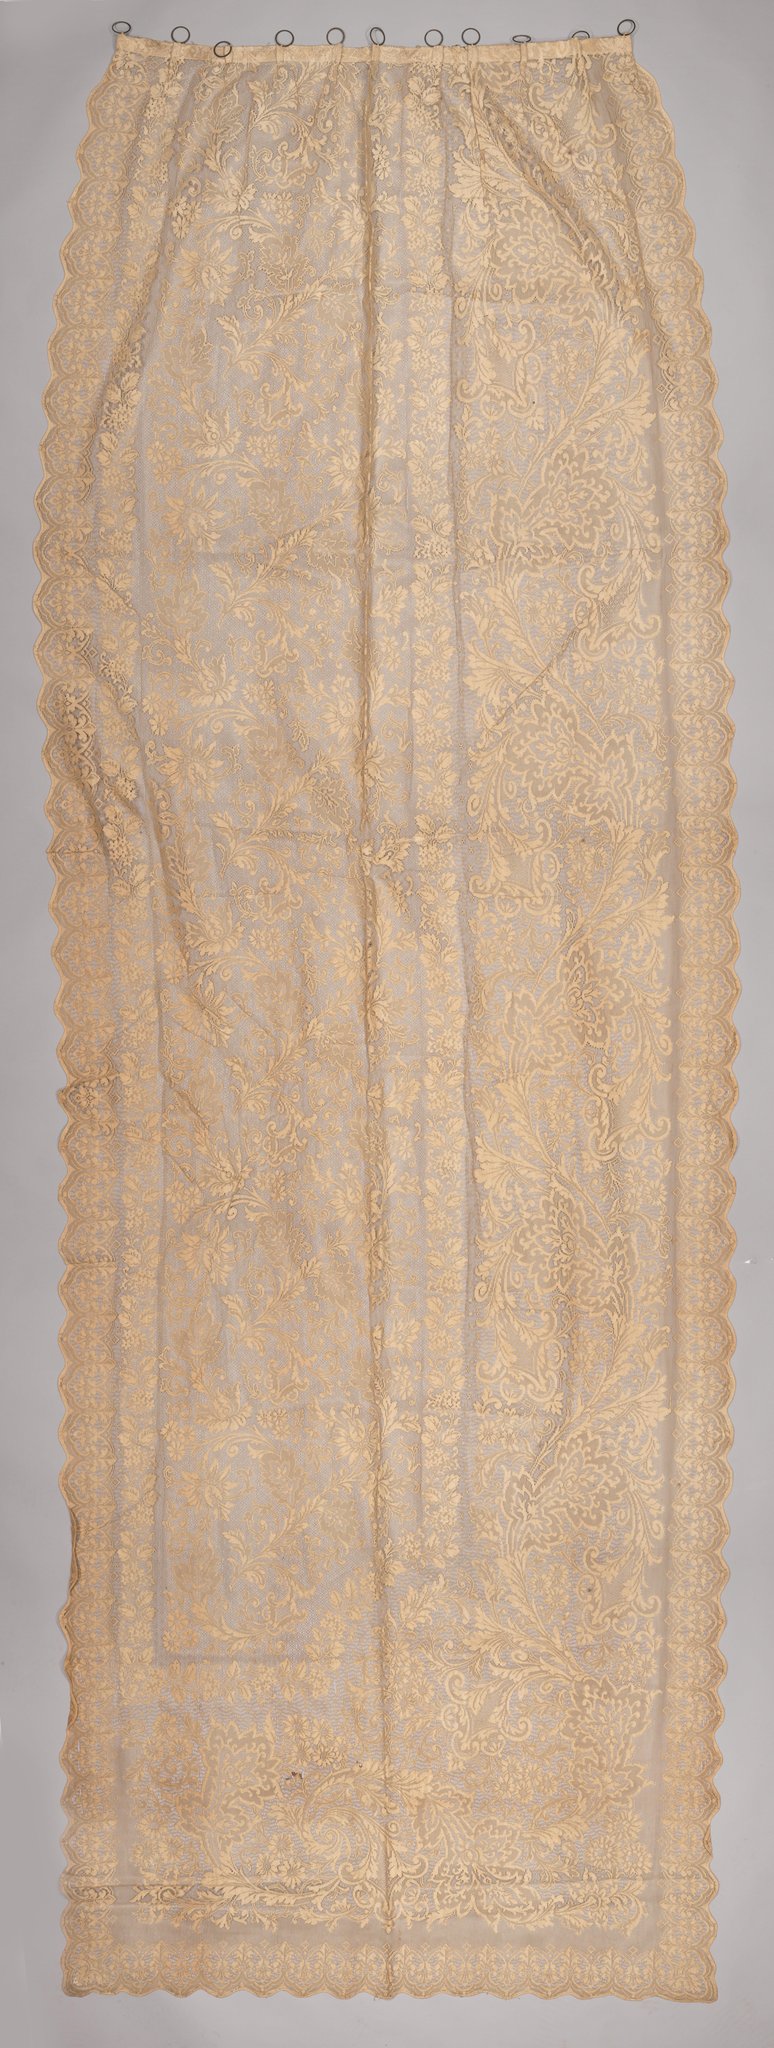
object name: sheer curtain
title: Vitrage van machinale kant met opgaande bloem- en bladranken binnen schulpranden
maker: Anonymous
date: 1890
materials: cotton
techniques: lace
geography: plauen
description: Vitrage van machinale kant. Het patroon heeft opgaande bloem- en bladranken binnen drie schulpranden. De vitrage heeft aangenaaide ringen.